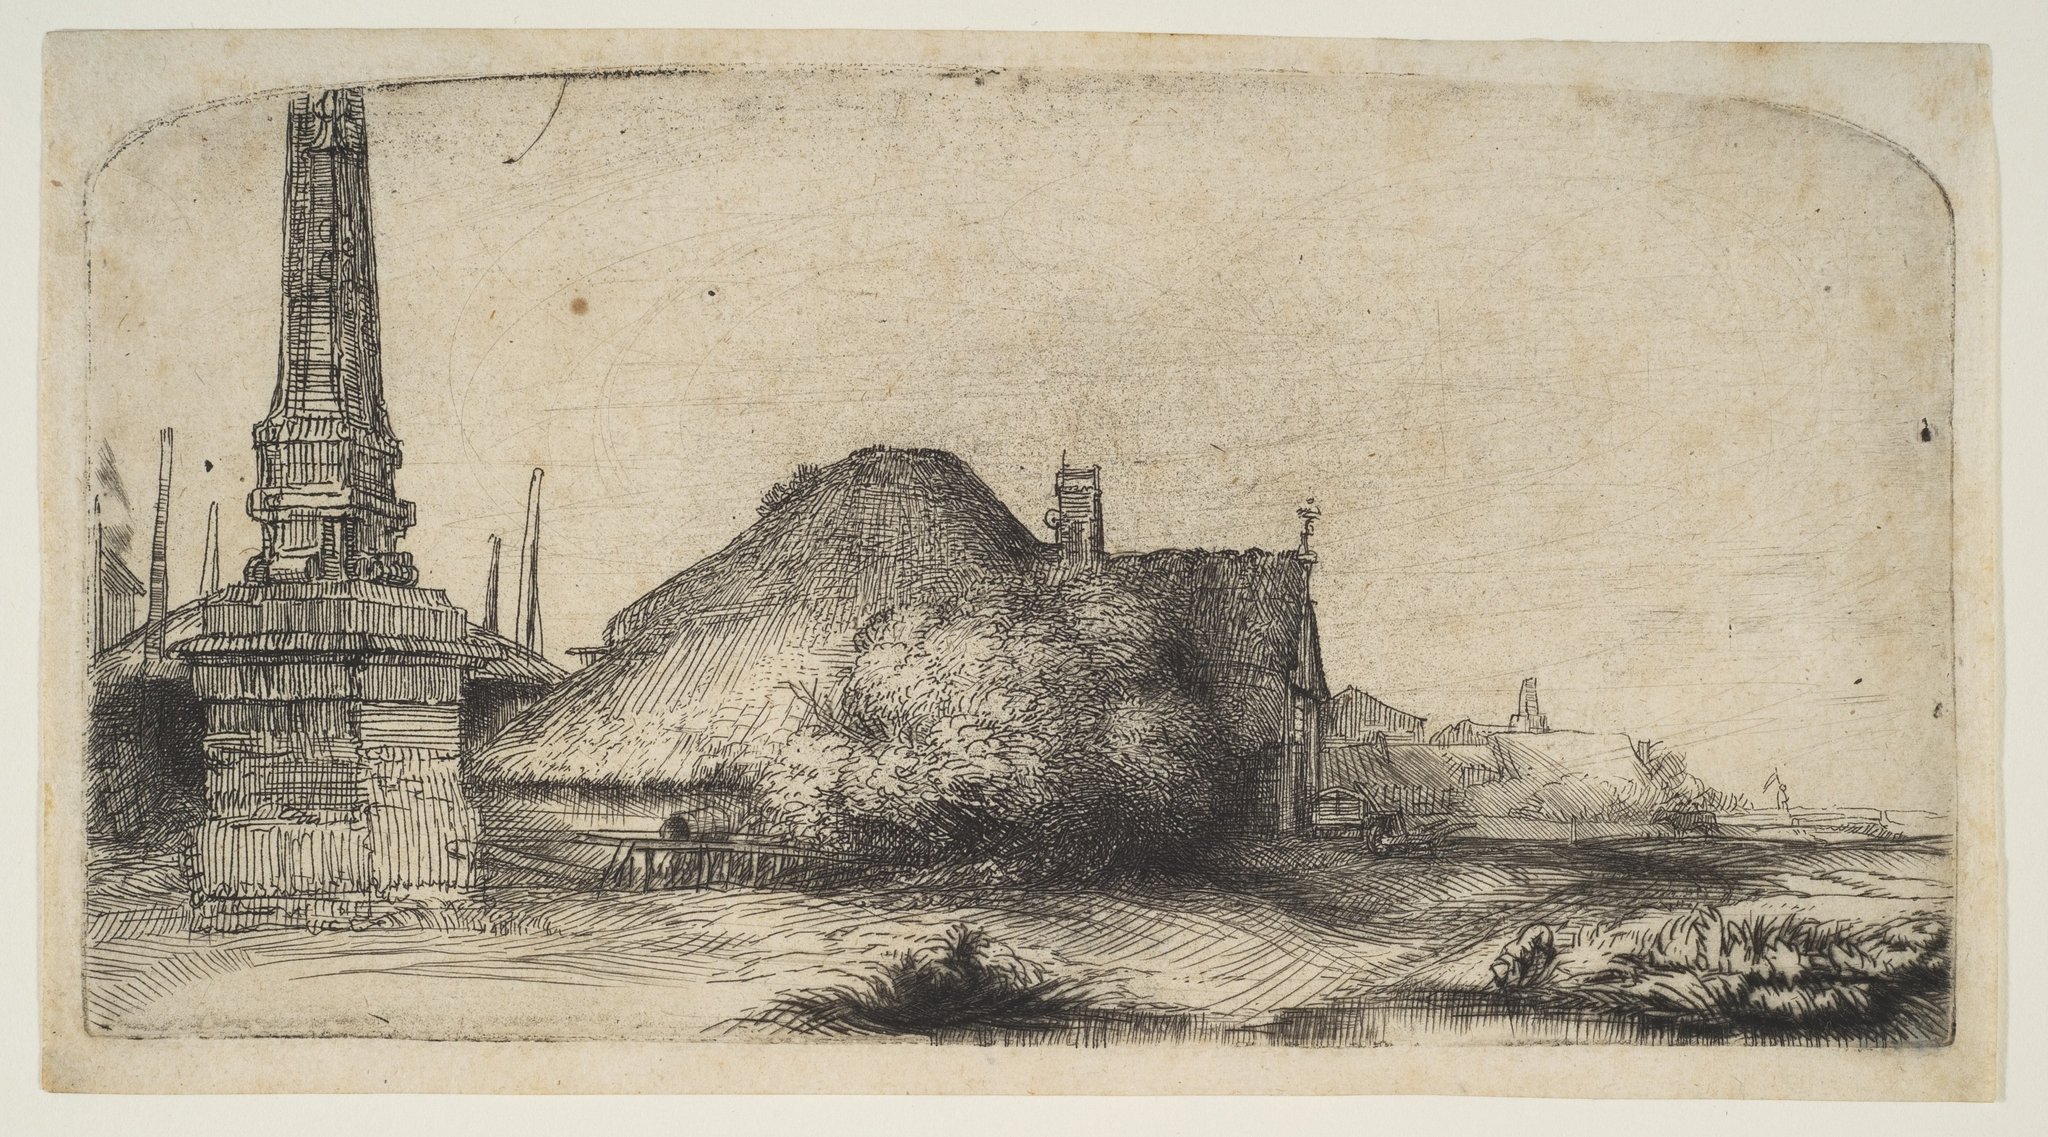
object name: print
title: Cottage and Boundary Post on the Spaarndammerdijk ('L'Obelisque')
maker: rembrandt van rijn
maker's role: artist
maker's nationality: dutch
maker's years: 1606-1669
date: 1650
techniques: drypoint, etching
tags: houses,obelisks,landscapes